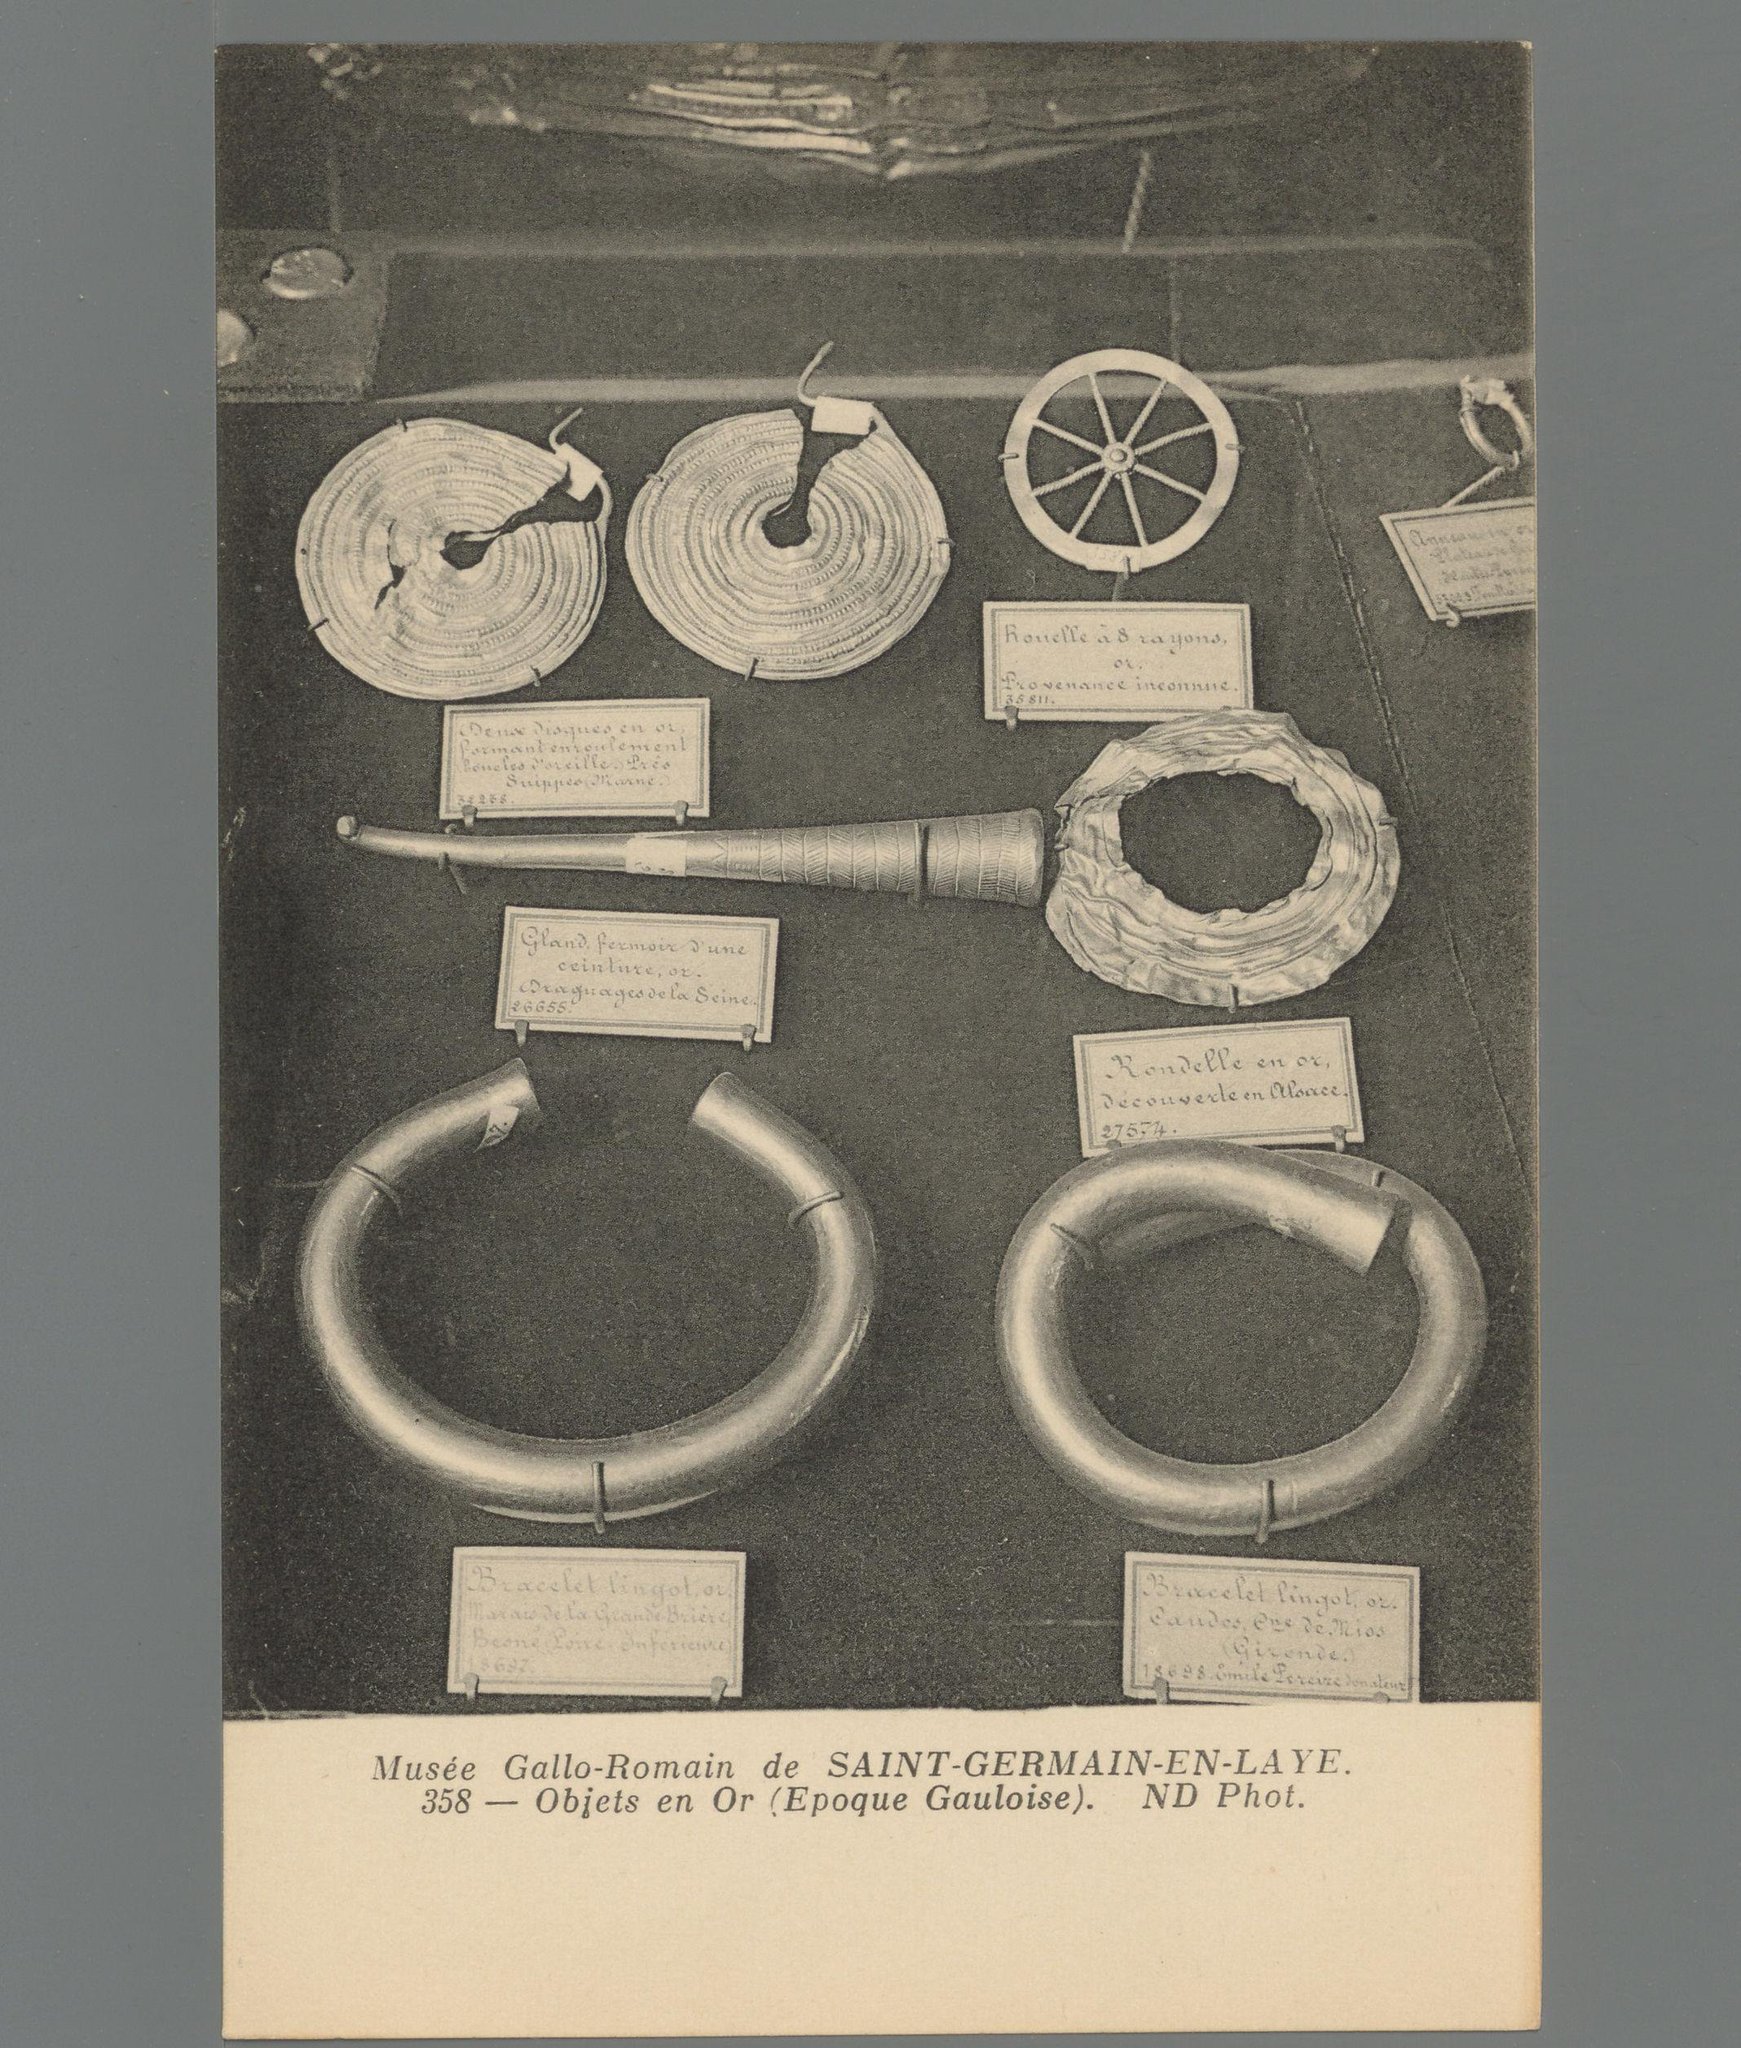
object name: photomechanical print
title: Objets en Or (Epoque Gauloise)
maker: Anonymous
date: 1903-1918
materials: cardboard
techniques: photograph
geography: saint-germain-en-laye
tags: ornaments, jewels, permanent exhibition, museum, minerals and metals: gold